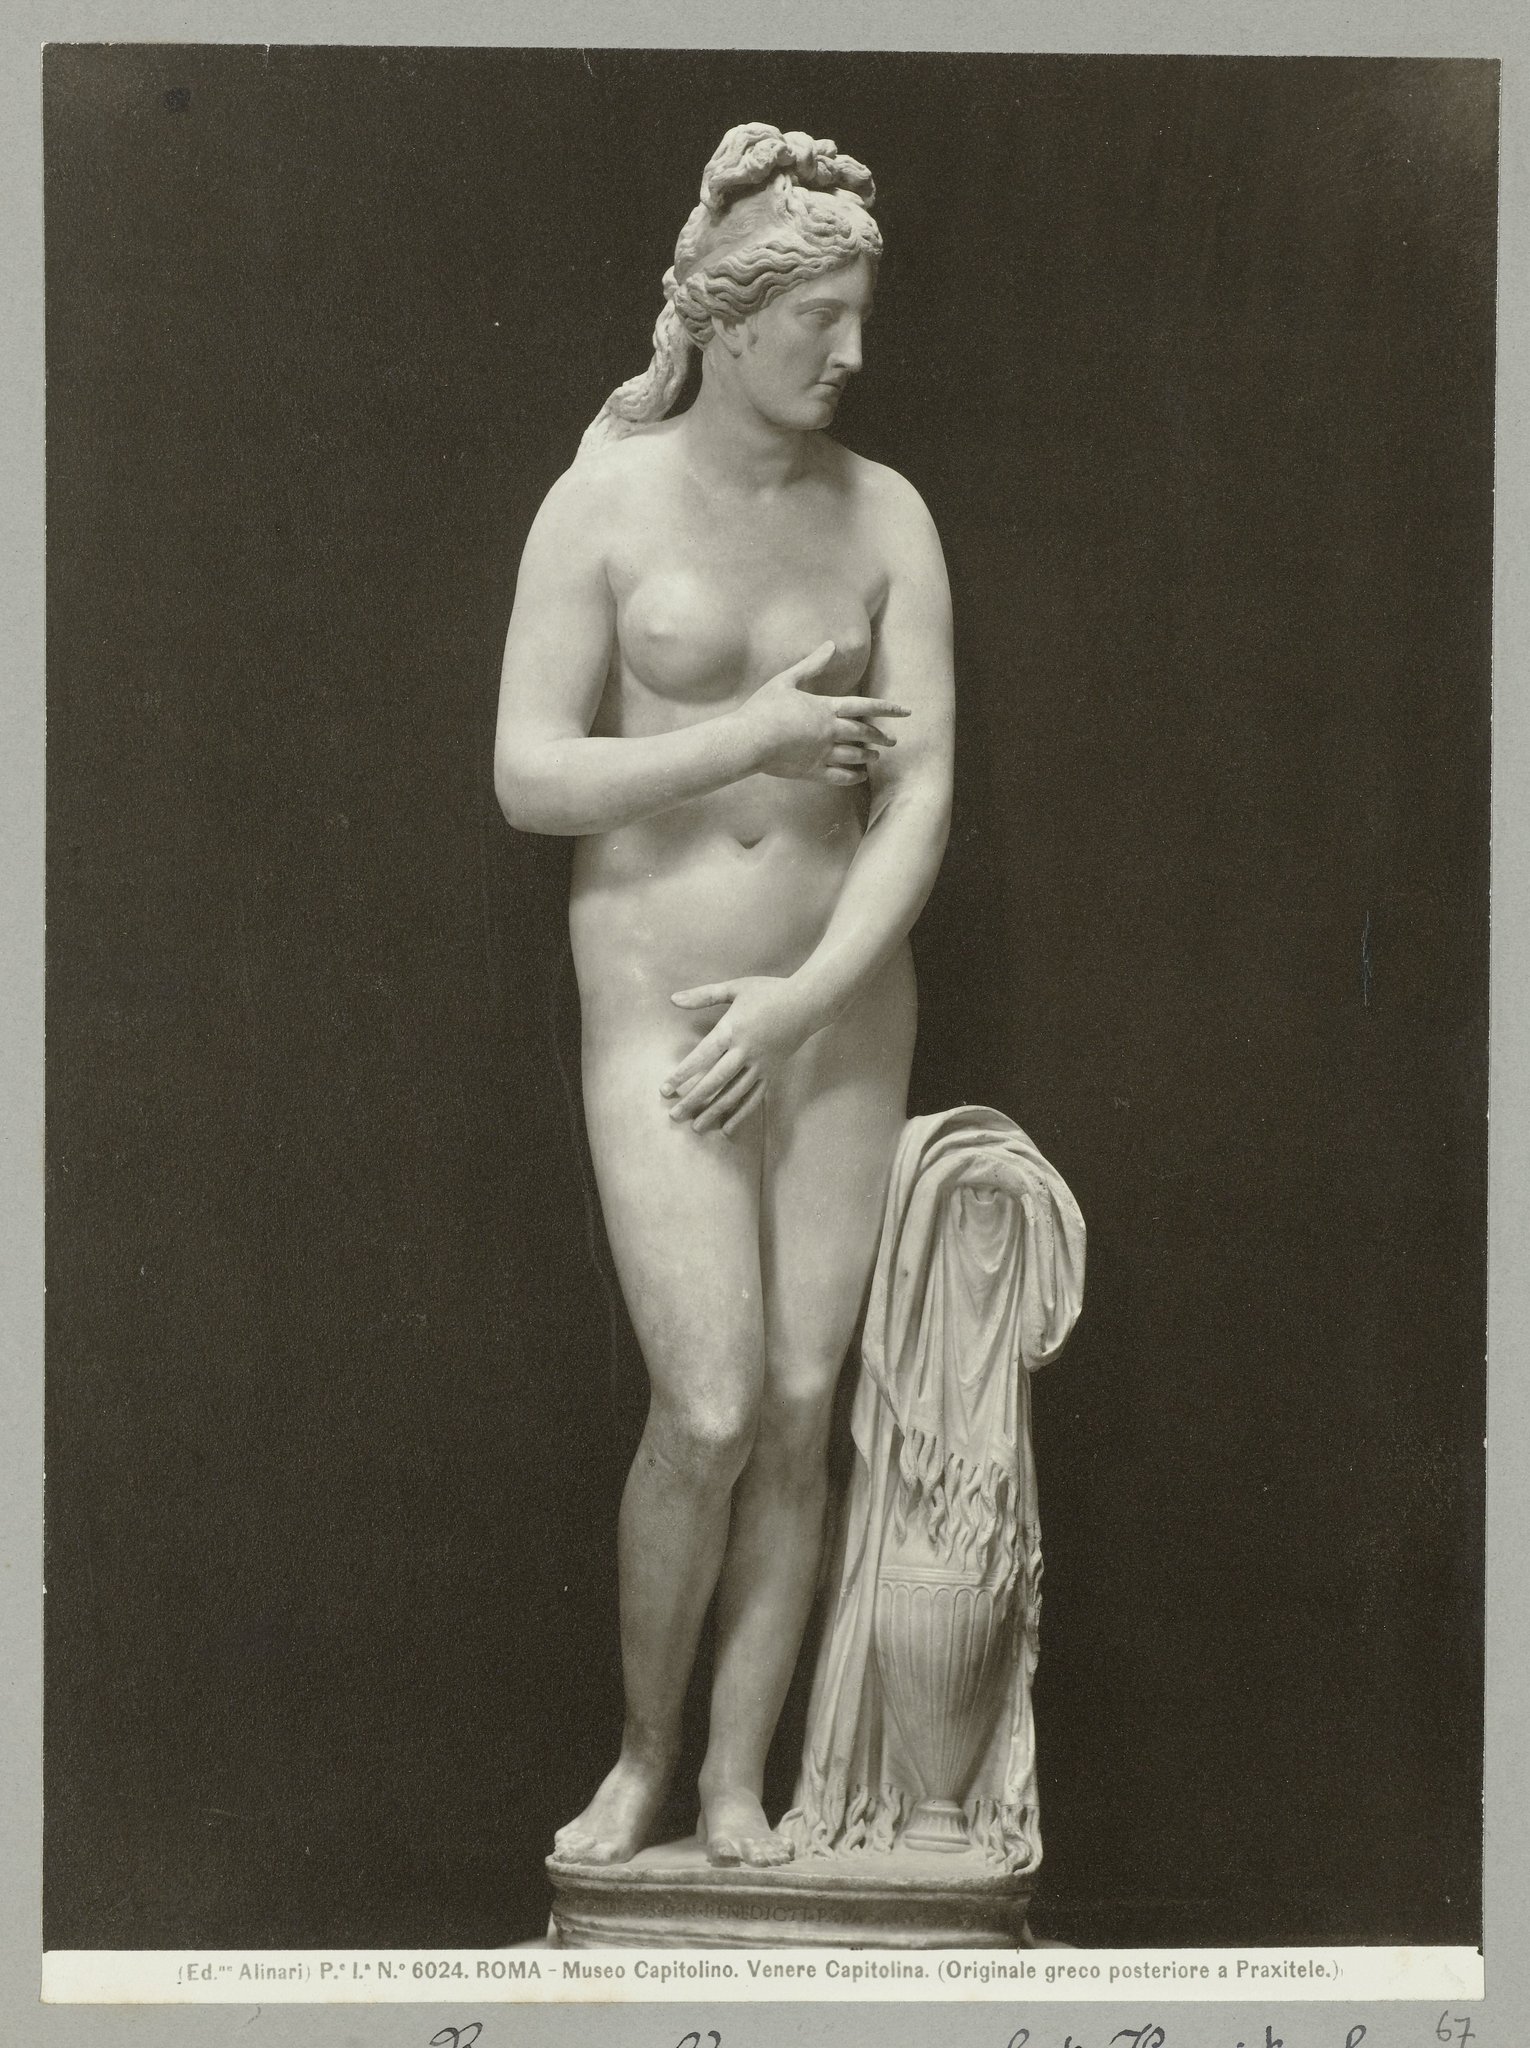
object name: photograph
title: P.I.N. 6024, Roma- Museo Capitolino. Venere Capitolina (Originale greco posteriore a Praxitele)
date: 1893-1903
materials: cardboard, photographic support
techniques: albumen print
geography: rome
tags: capitool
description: Een marmeren beeld van een staande Venus.